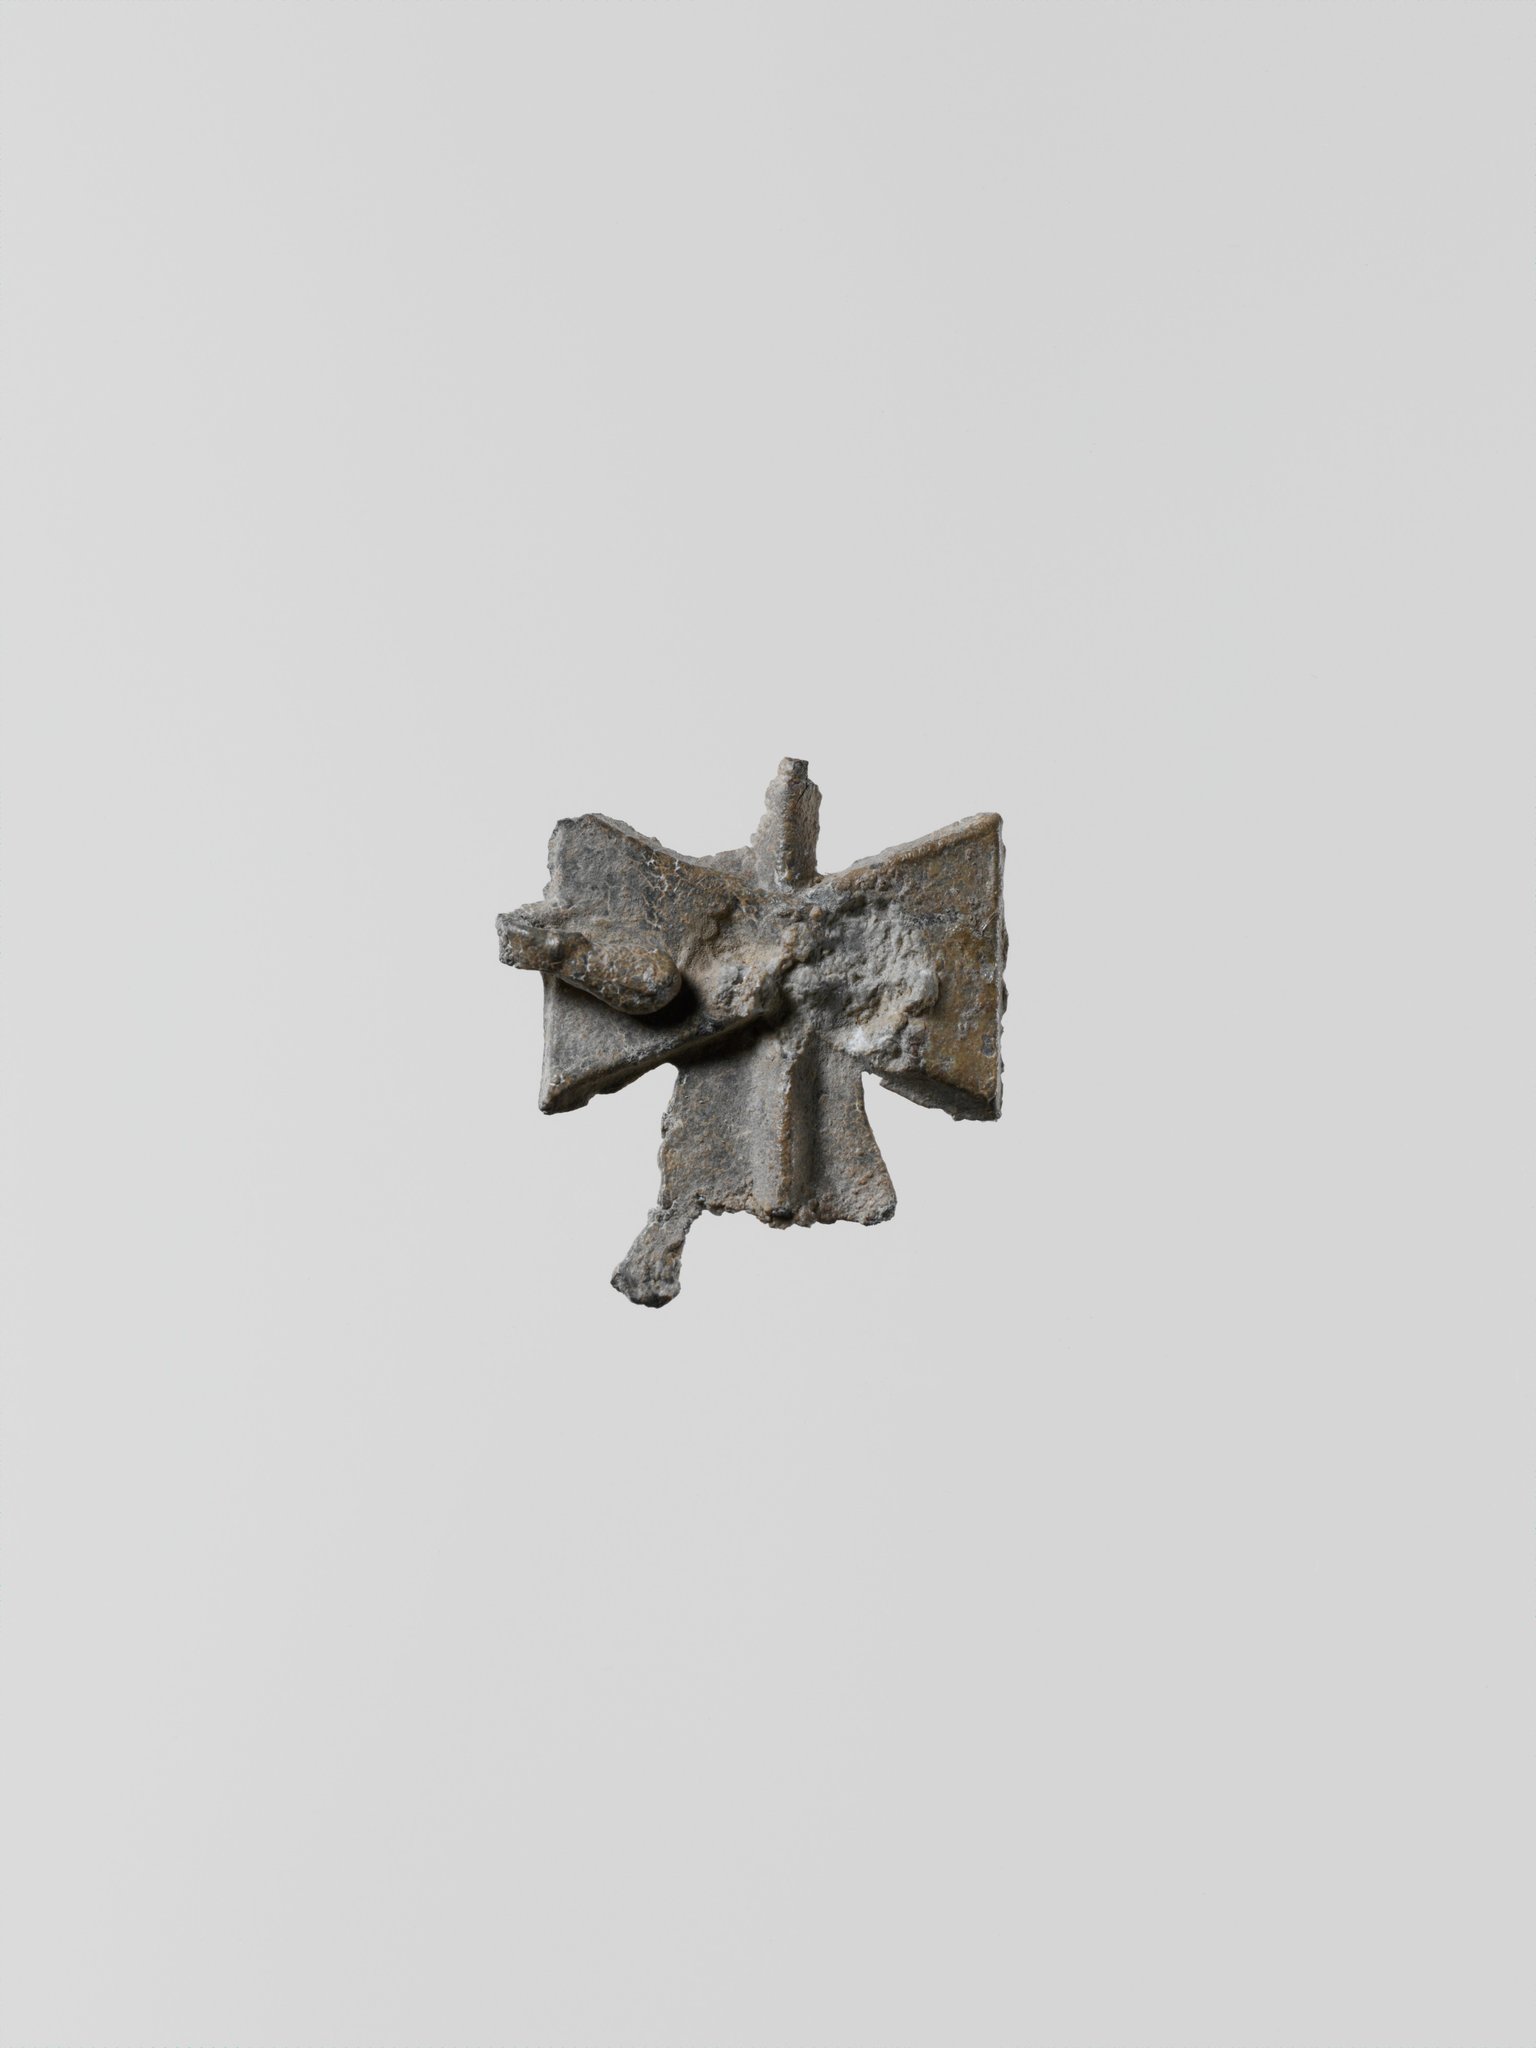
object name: ornament, 14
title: Ornaments, 14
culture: greek, laconian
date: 7000-30 BCE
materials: lead